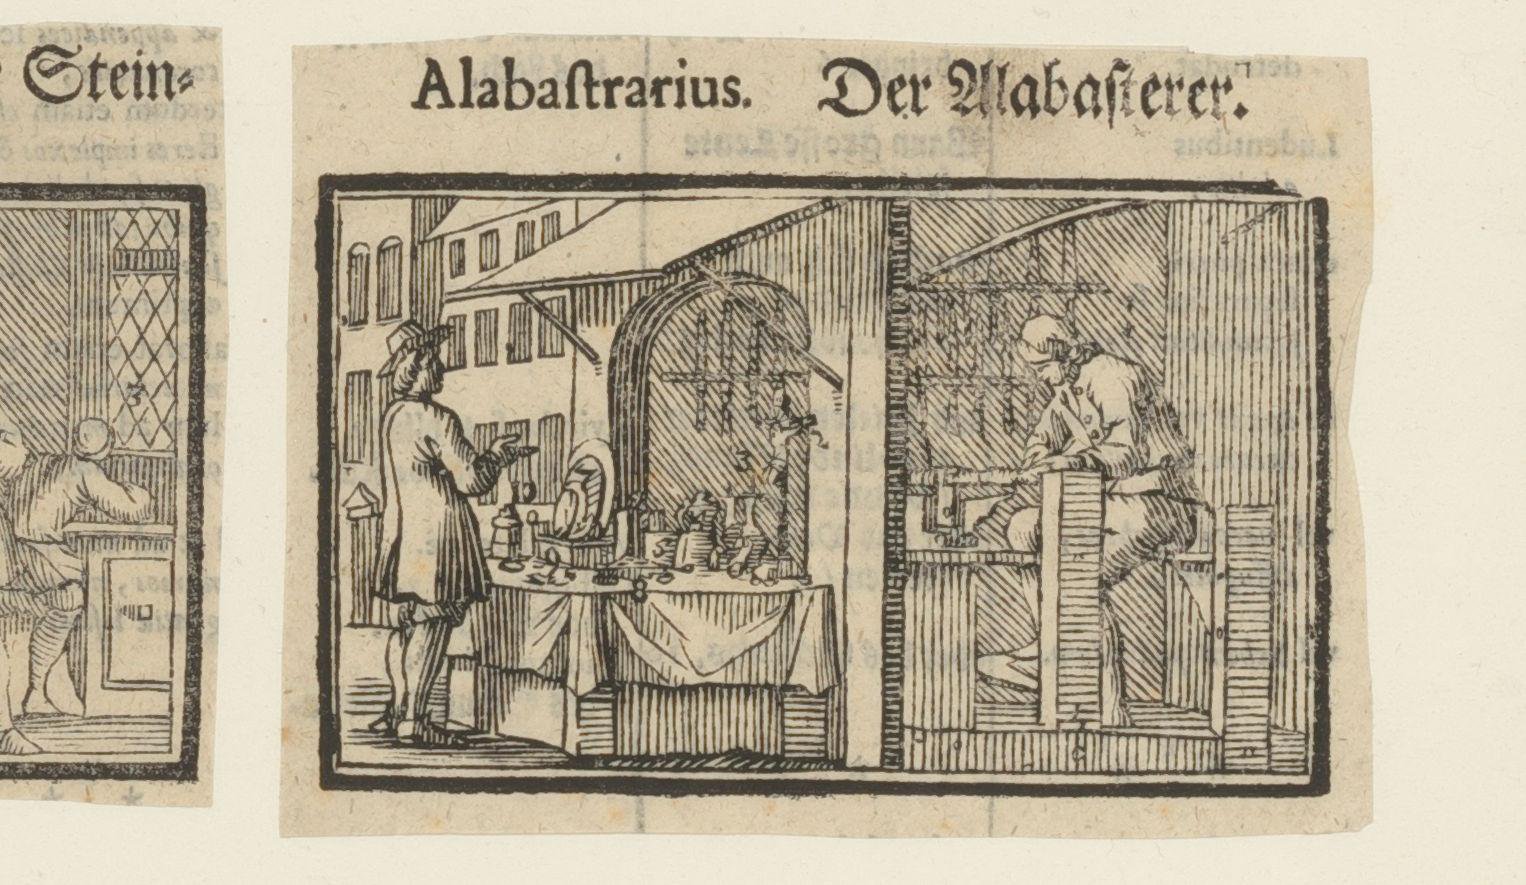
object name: print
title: Alabastrarius. Der Alabasterer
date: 1719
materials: paper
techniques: letterpress printing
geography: nuremberg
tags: handicrafts, craftsman at work, handicrafts ~ stone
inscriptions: stamp, collector's mark: Lugt 1641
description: Werkplaats van een albastwerker aan een slijpwiel. Aan de voorzijde is zijn winkel met een uitstalling van de koopwaar, zoals een crucifix, schalen, bekers, een kruik en zoutvaten. Onderwerpsrubrieken binnen de Atlas Zeden en Gewoonten: Handel, Nijverheid en Verkeer, Beroep en bedrijf, Complete suites.